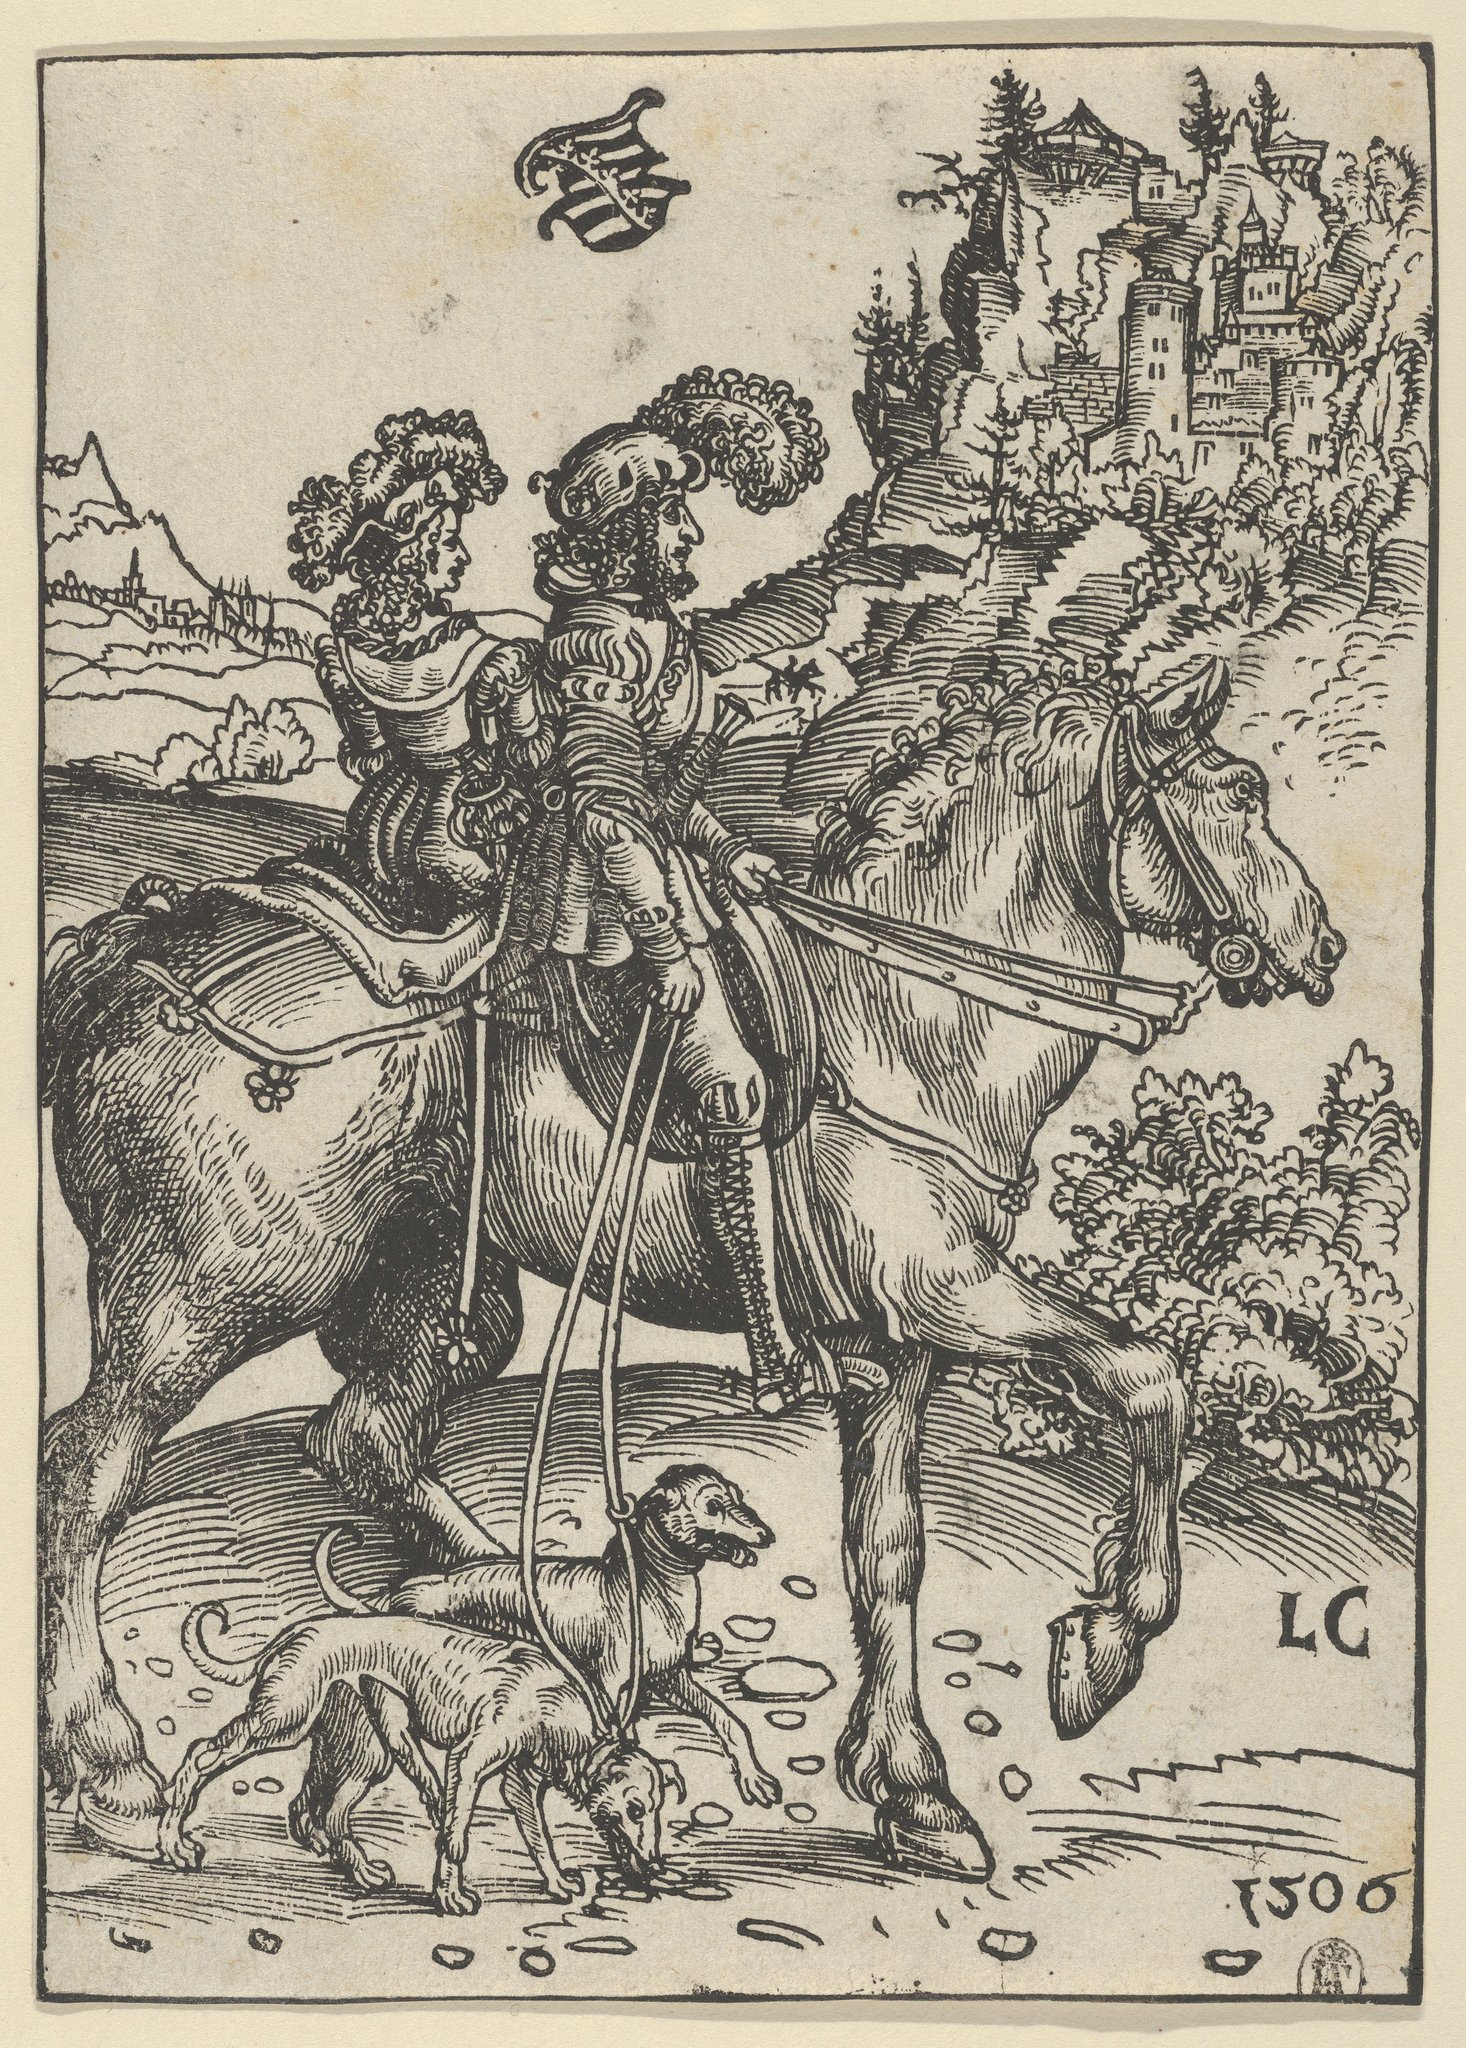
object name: print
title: Gentleman and Lady Riding to the Hunt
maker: lucas cranach the elder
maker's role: artist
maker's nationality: german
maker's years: 1472-1553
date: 1472-1553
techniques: woodcut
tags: buildings,men,women,dogs,horses,hills,coat of arms